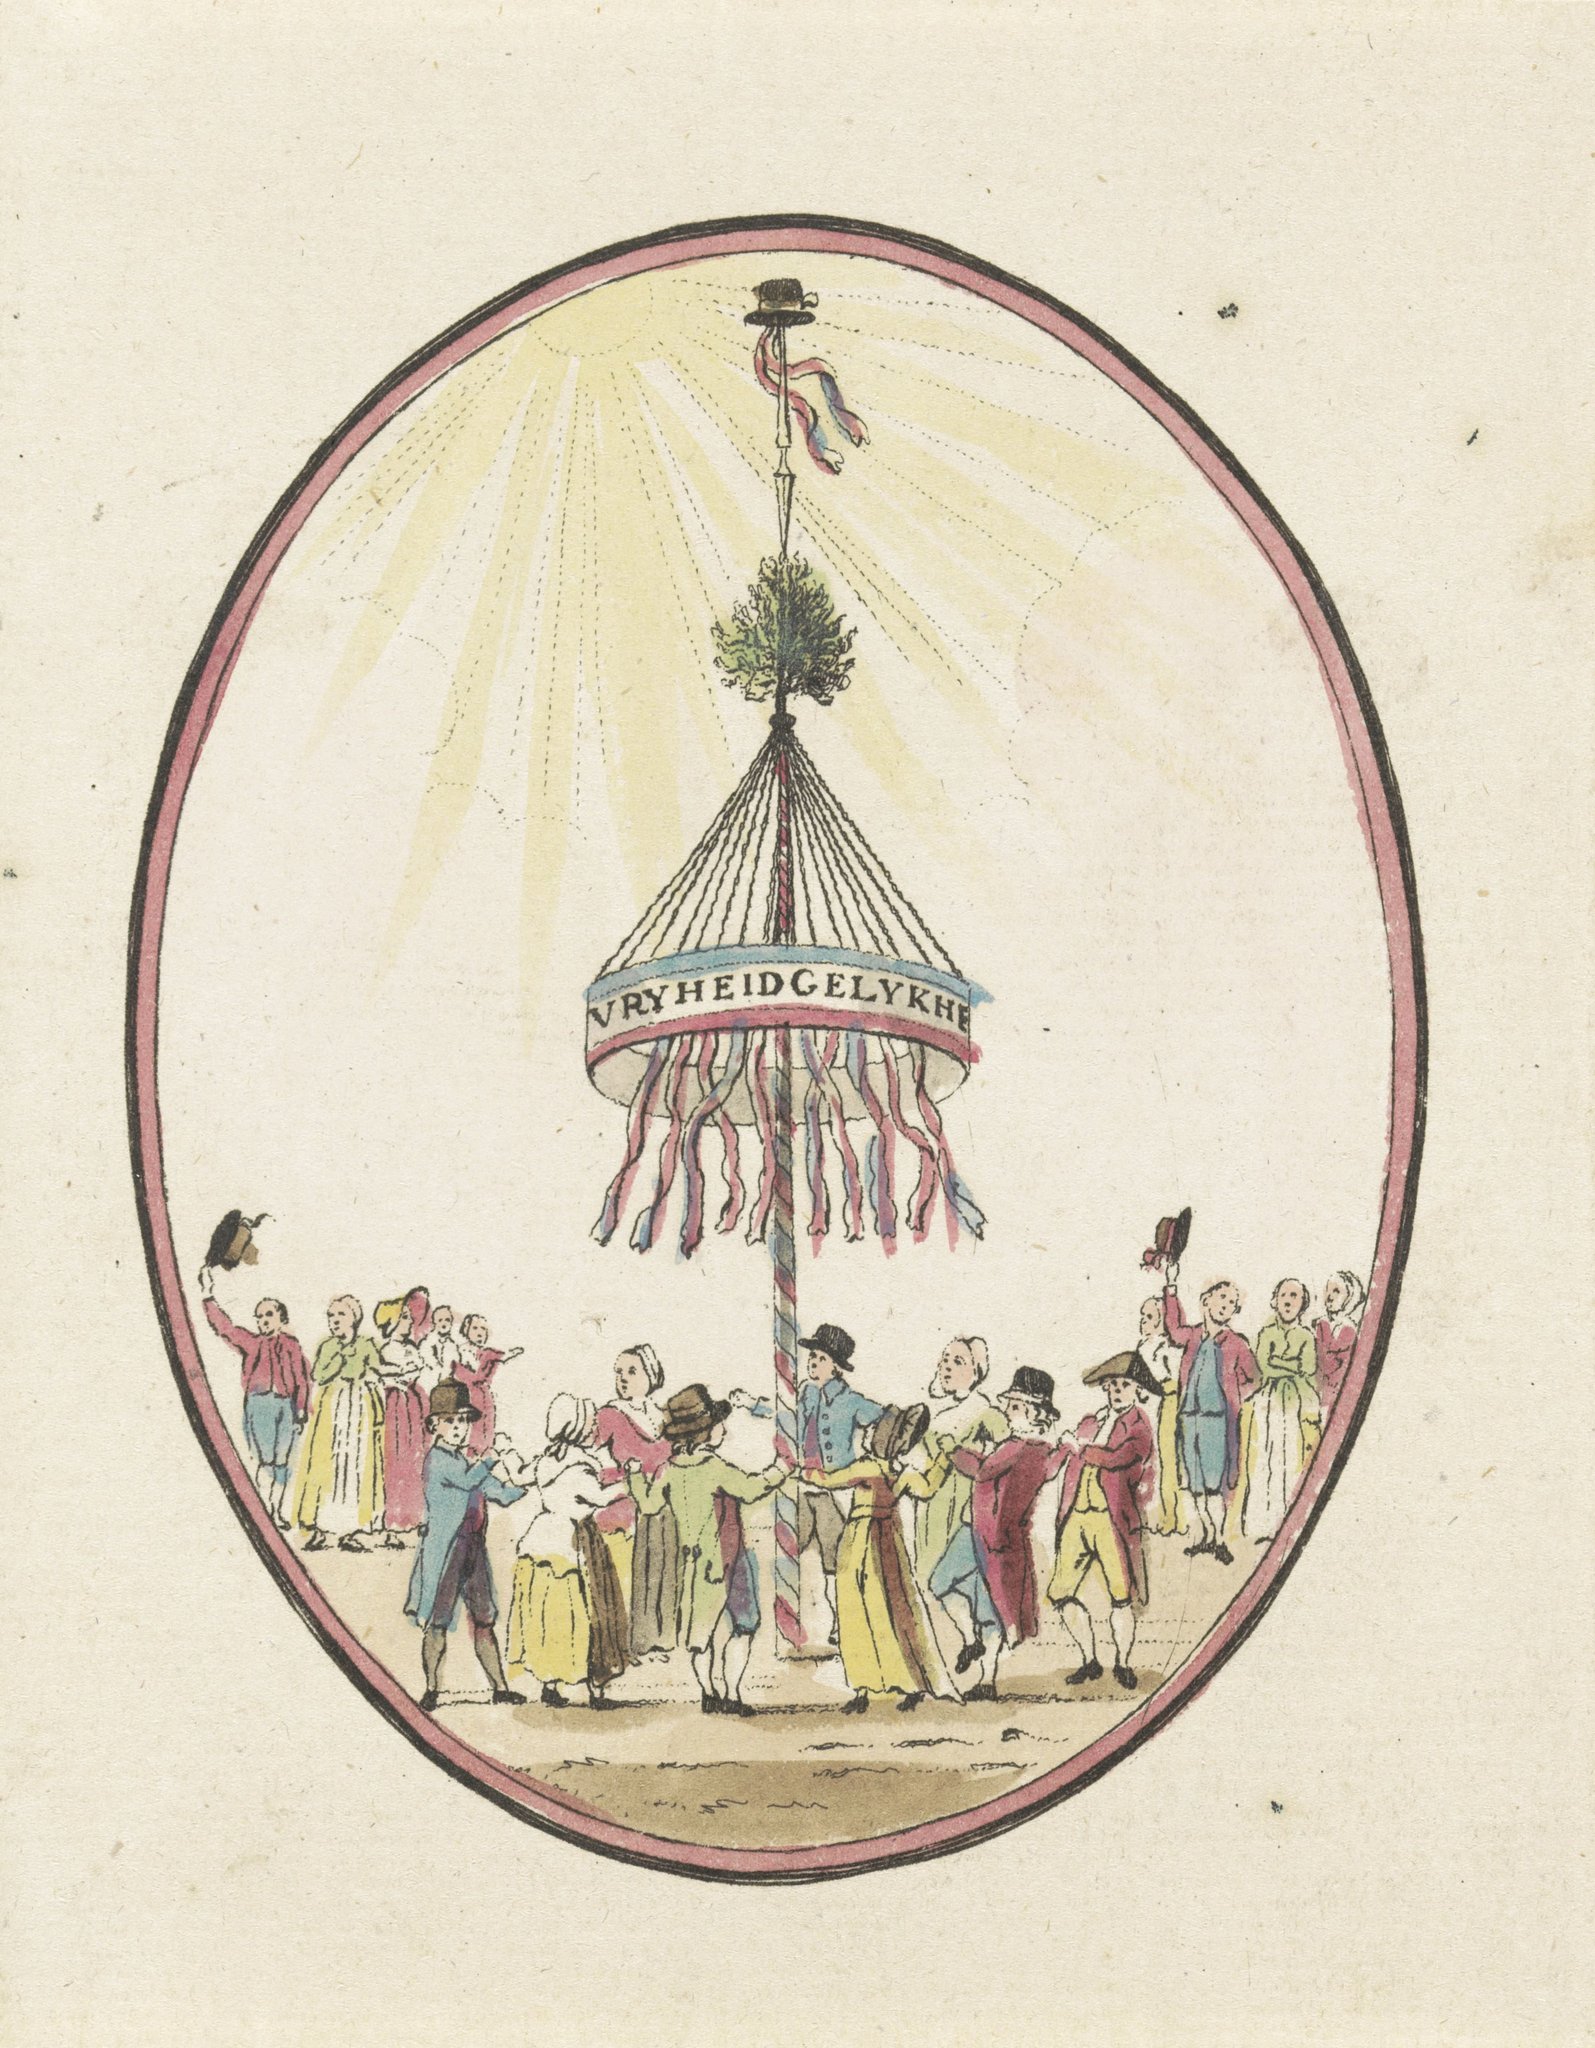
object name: print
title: Vrijheidsboom op Burgerplein te Amsterdam, 1795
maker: Anonymous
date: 1795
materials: paper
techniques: etching, hand coloring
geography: netherlands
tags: dancing around the tree of liberty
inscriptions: collector's mark: Lugt 2228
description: Ovale voorstelling van het dansen om de vrijheidsboom geplant in de nacht van 5 op 6 februari 1795 op het Koningsplein, destijds omgedoopt tot Burgerplein, te Amsterdam.